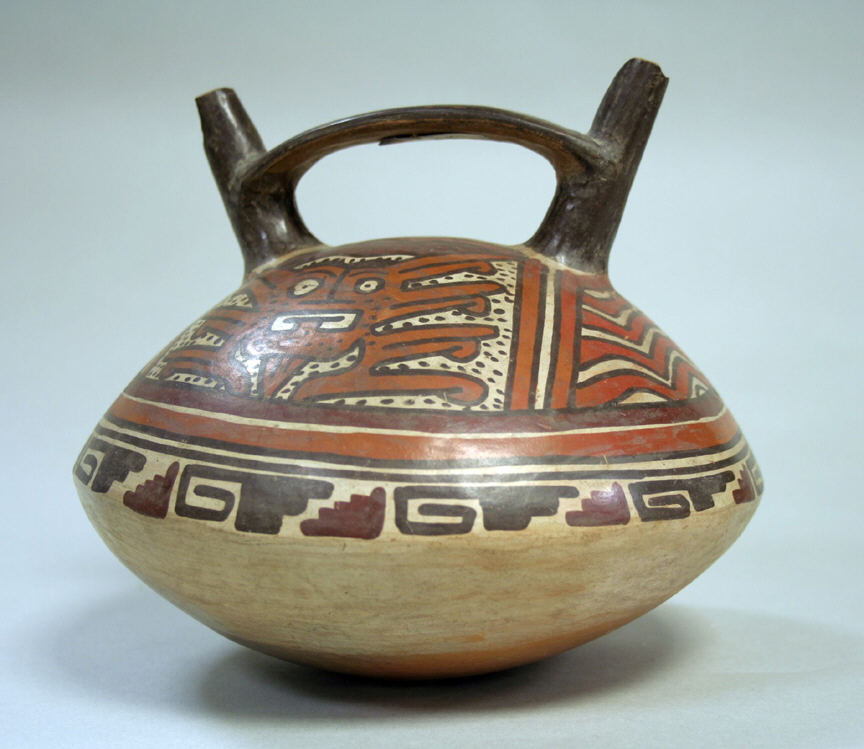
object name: bottle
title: Double Spout Bottle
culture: nasca-wari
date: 1-600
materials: ceramic, pigment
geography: peru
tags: demons